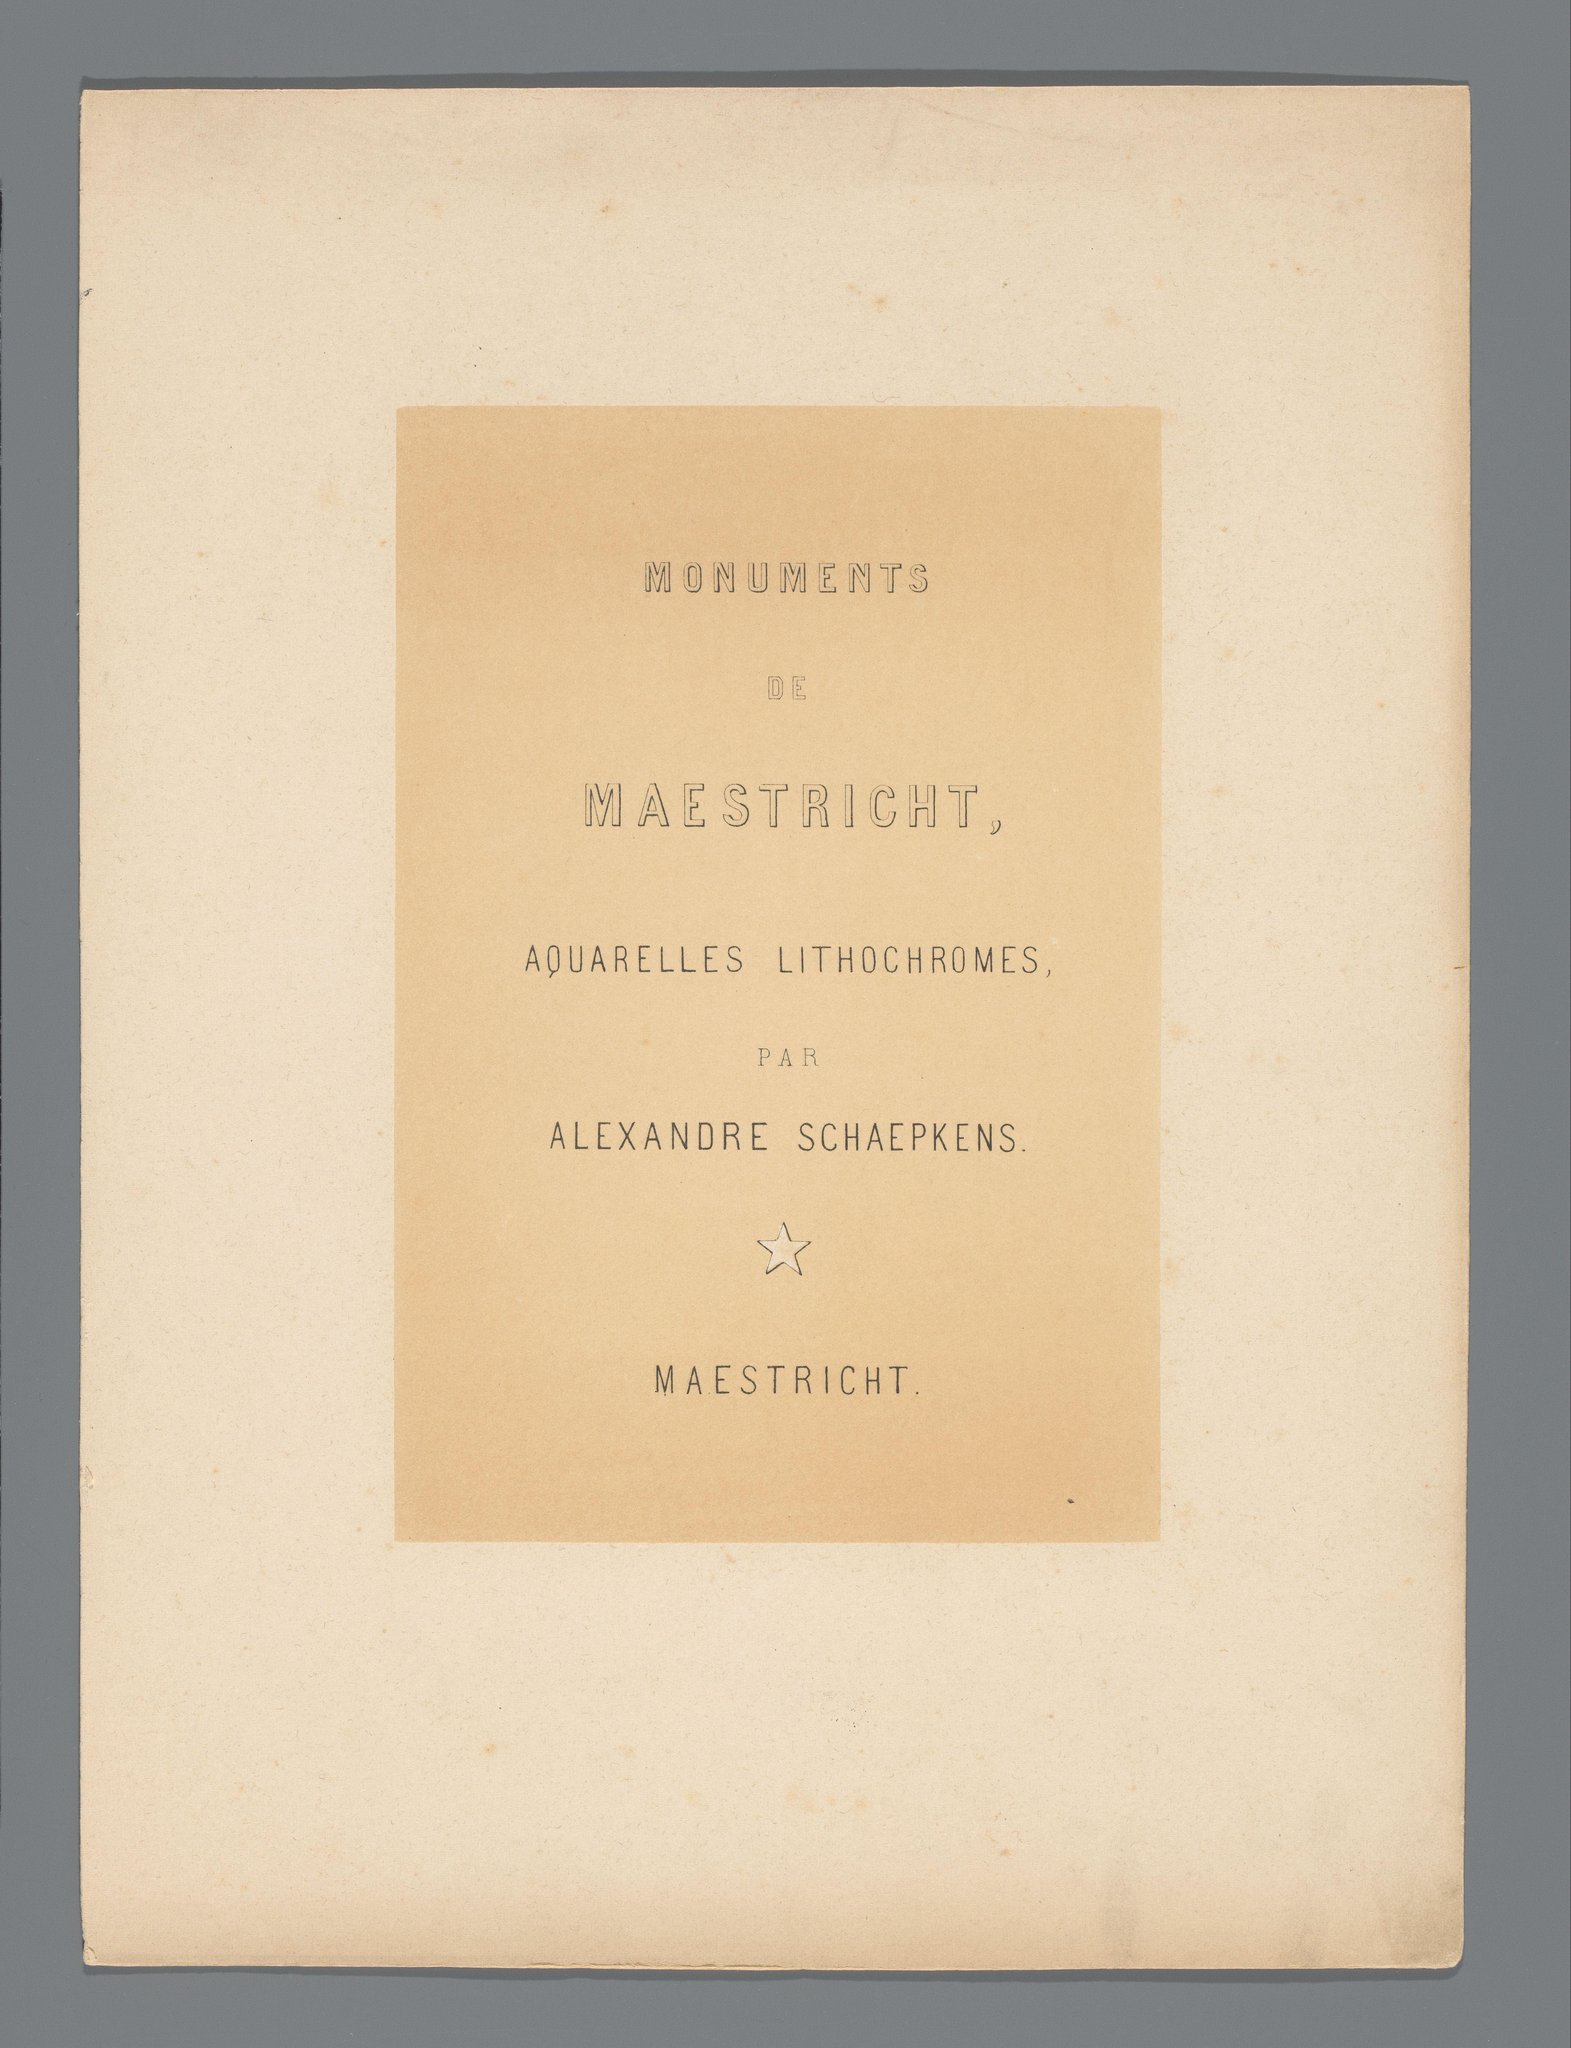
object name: titelprent, frontispice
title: Monuments de Maestricht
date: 1857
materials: paper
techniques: tone lithography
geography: brussels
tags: monument, statue, maastricht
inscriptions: collector's mark: Lugt 2228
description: Onderdeel van een omslag met een serie van tien lithografieën van monumenten te Maastricht.